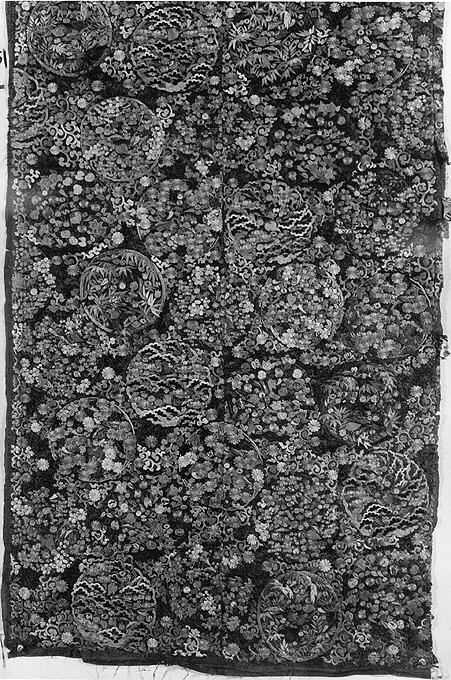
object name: piece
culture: japanese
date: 1667-1733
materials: metal thread, silk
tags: flowers,leaves